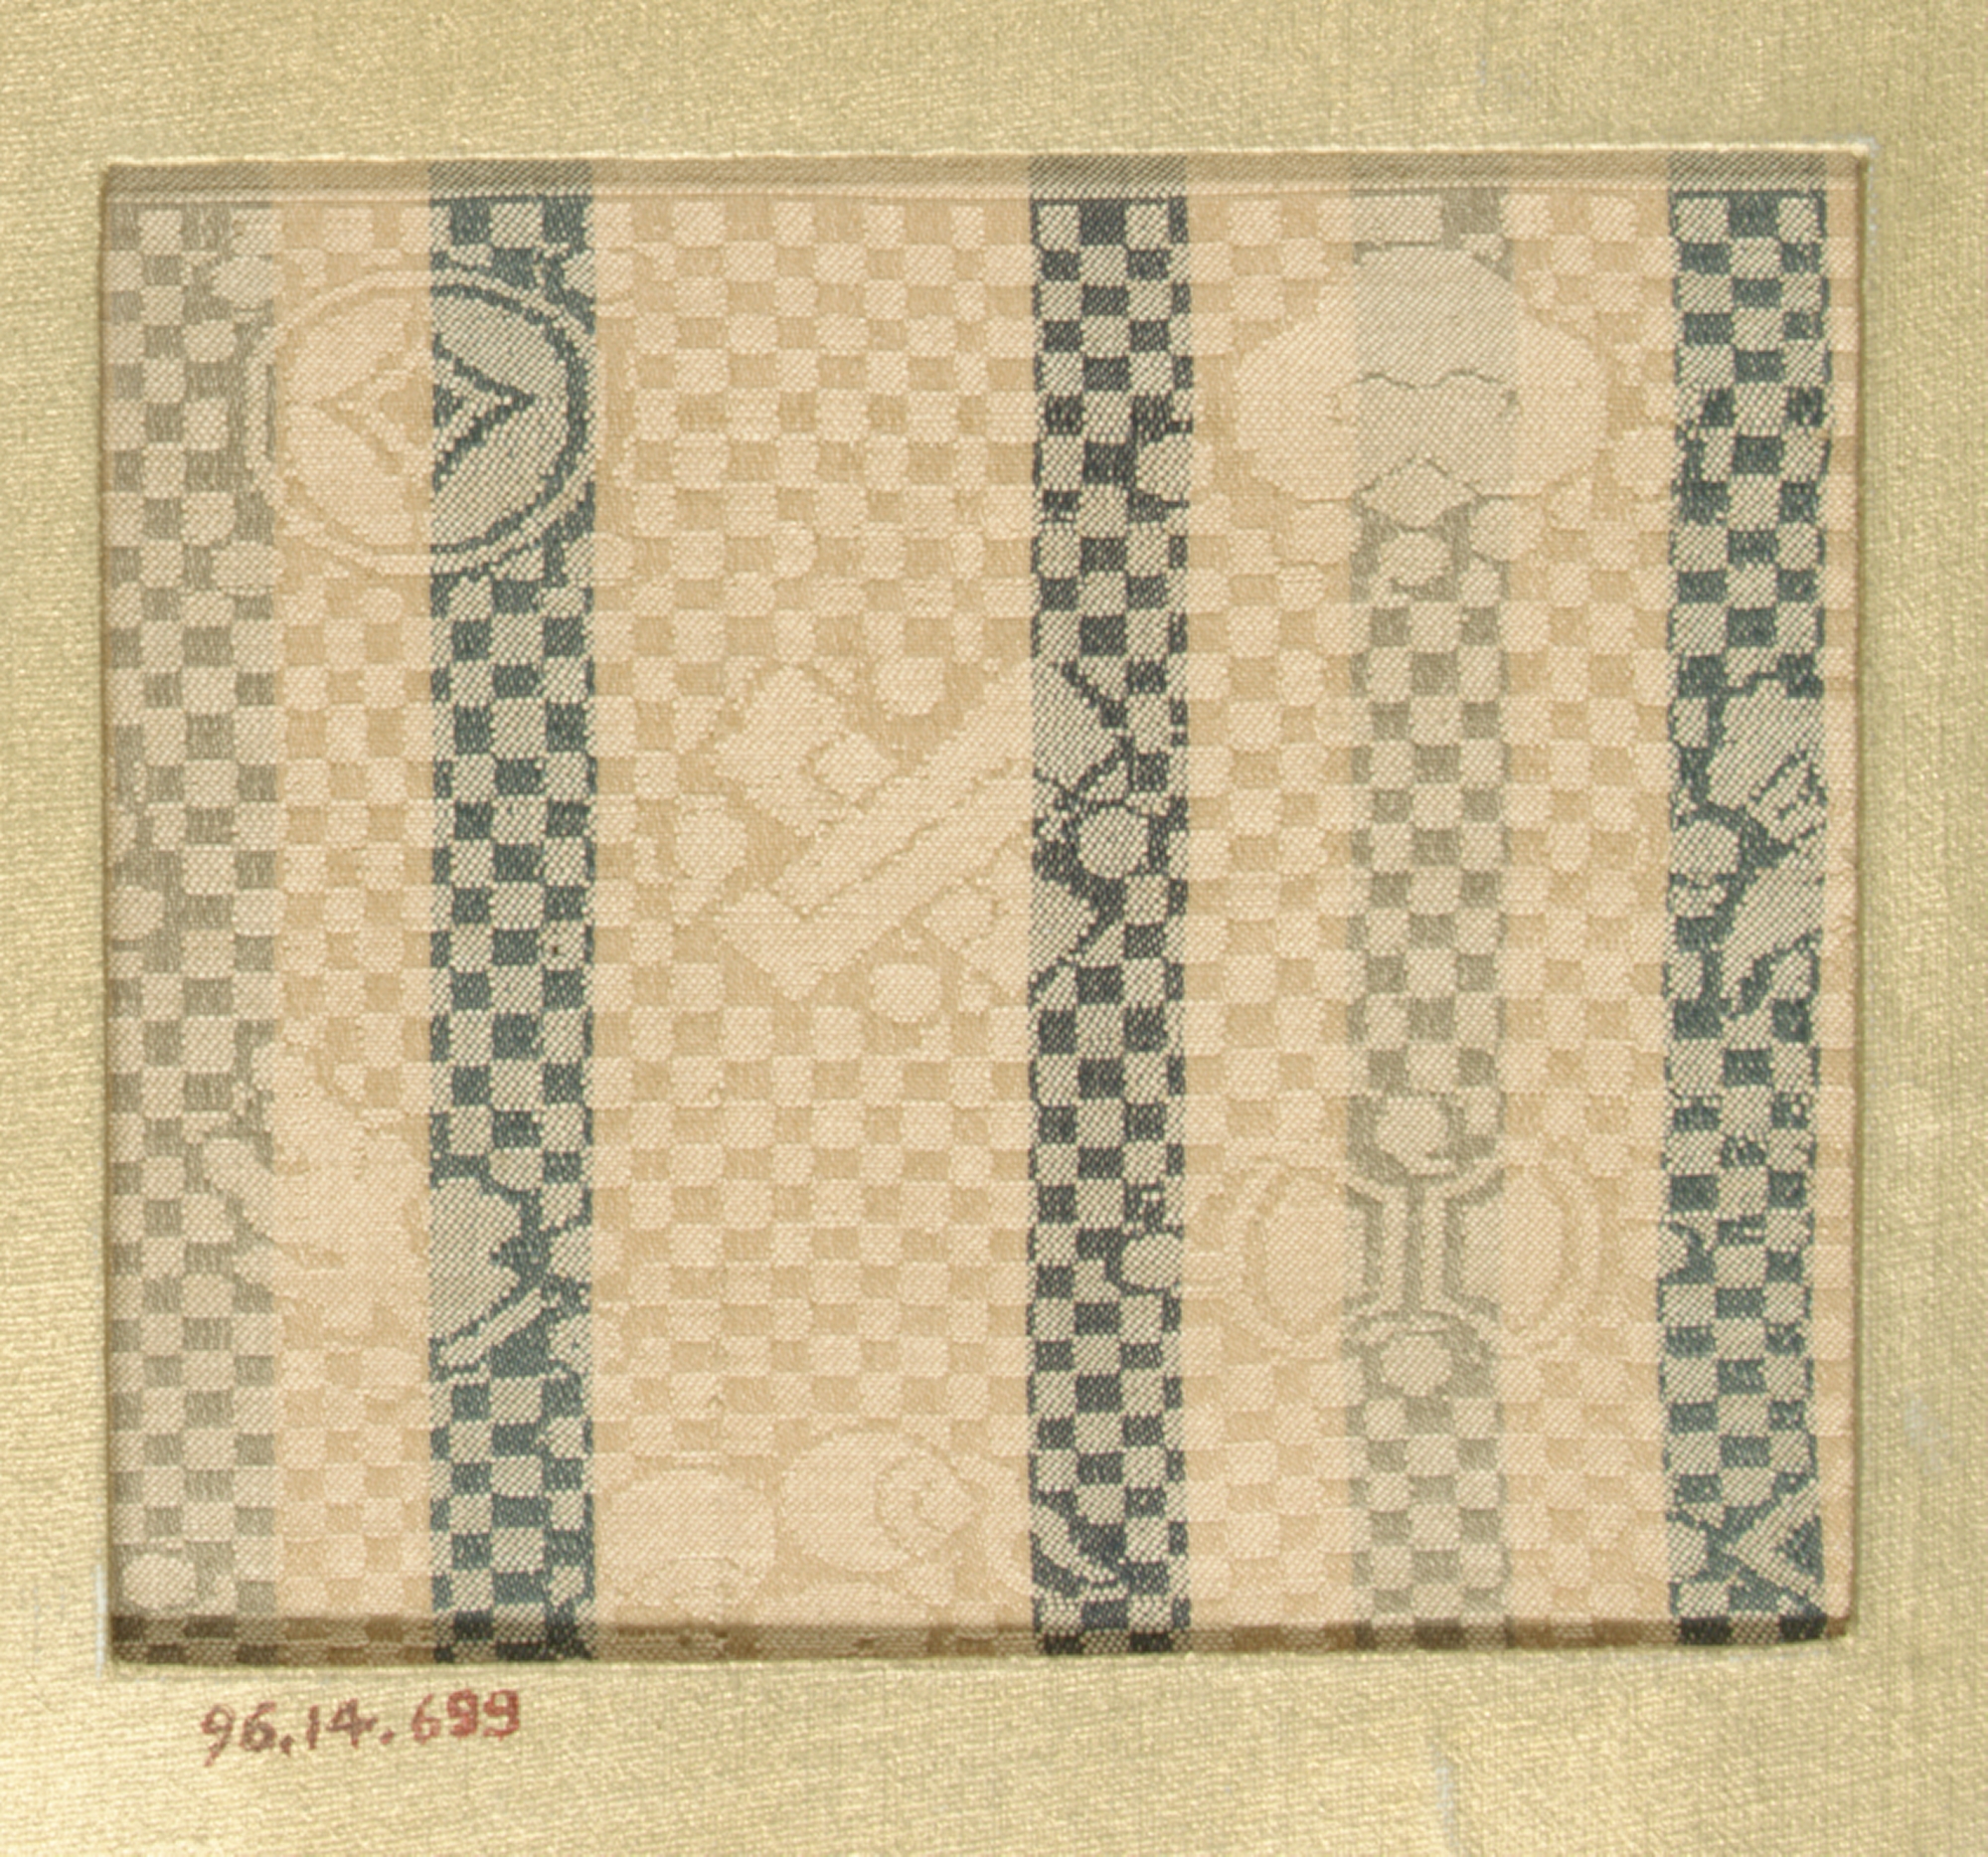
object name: piece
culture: japanese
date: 1701-1900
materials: silk